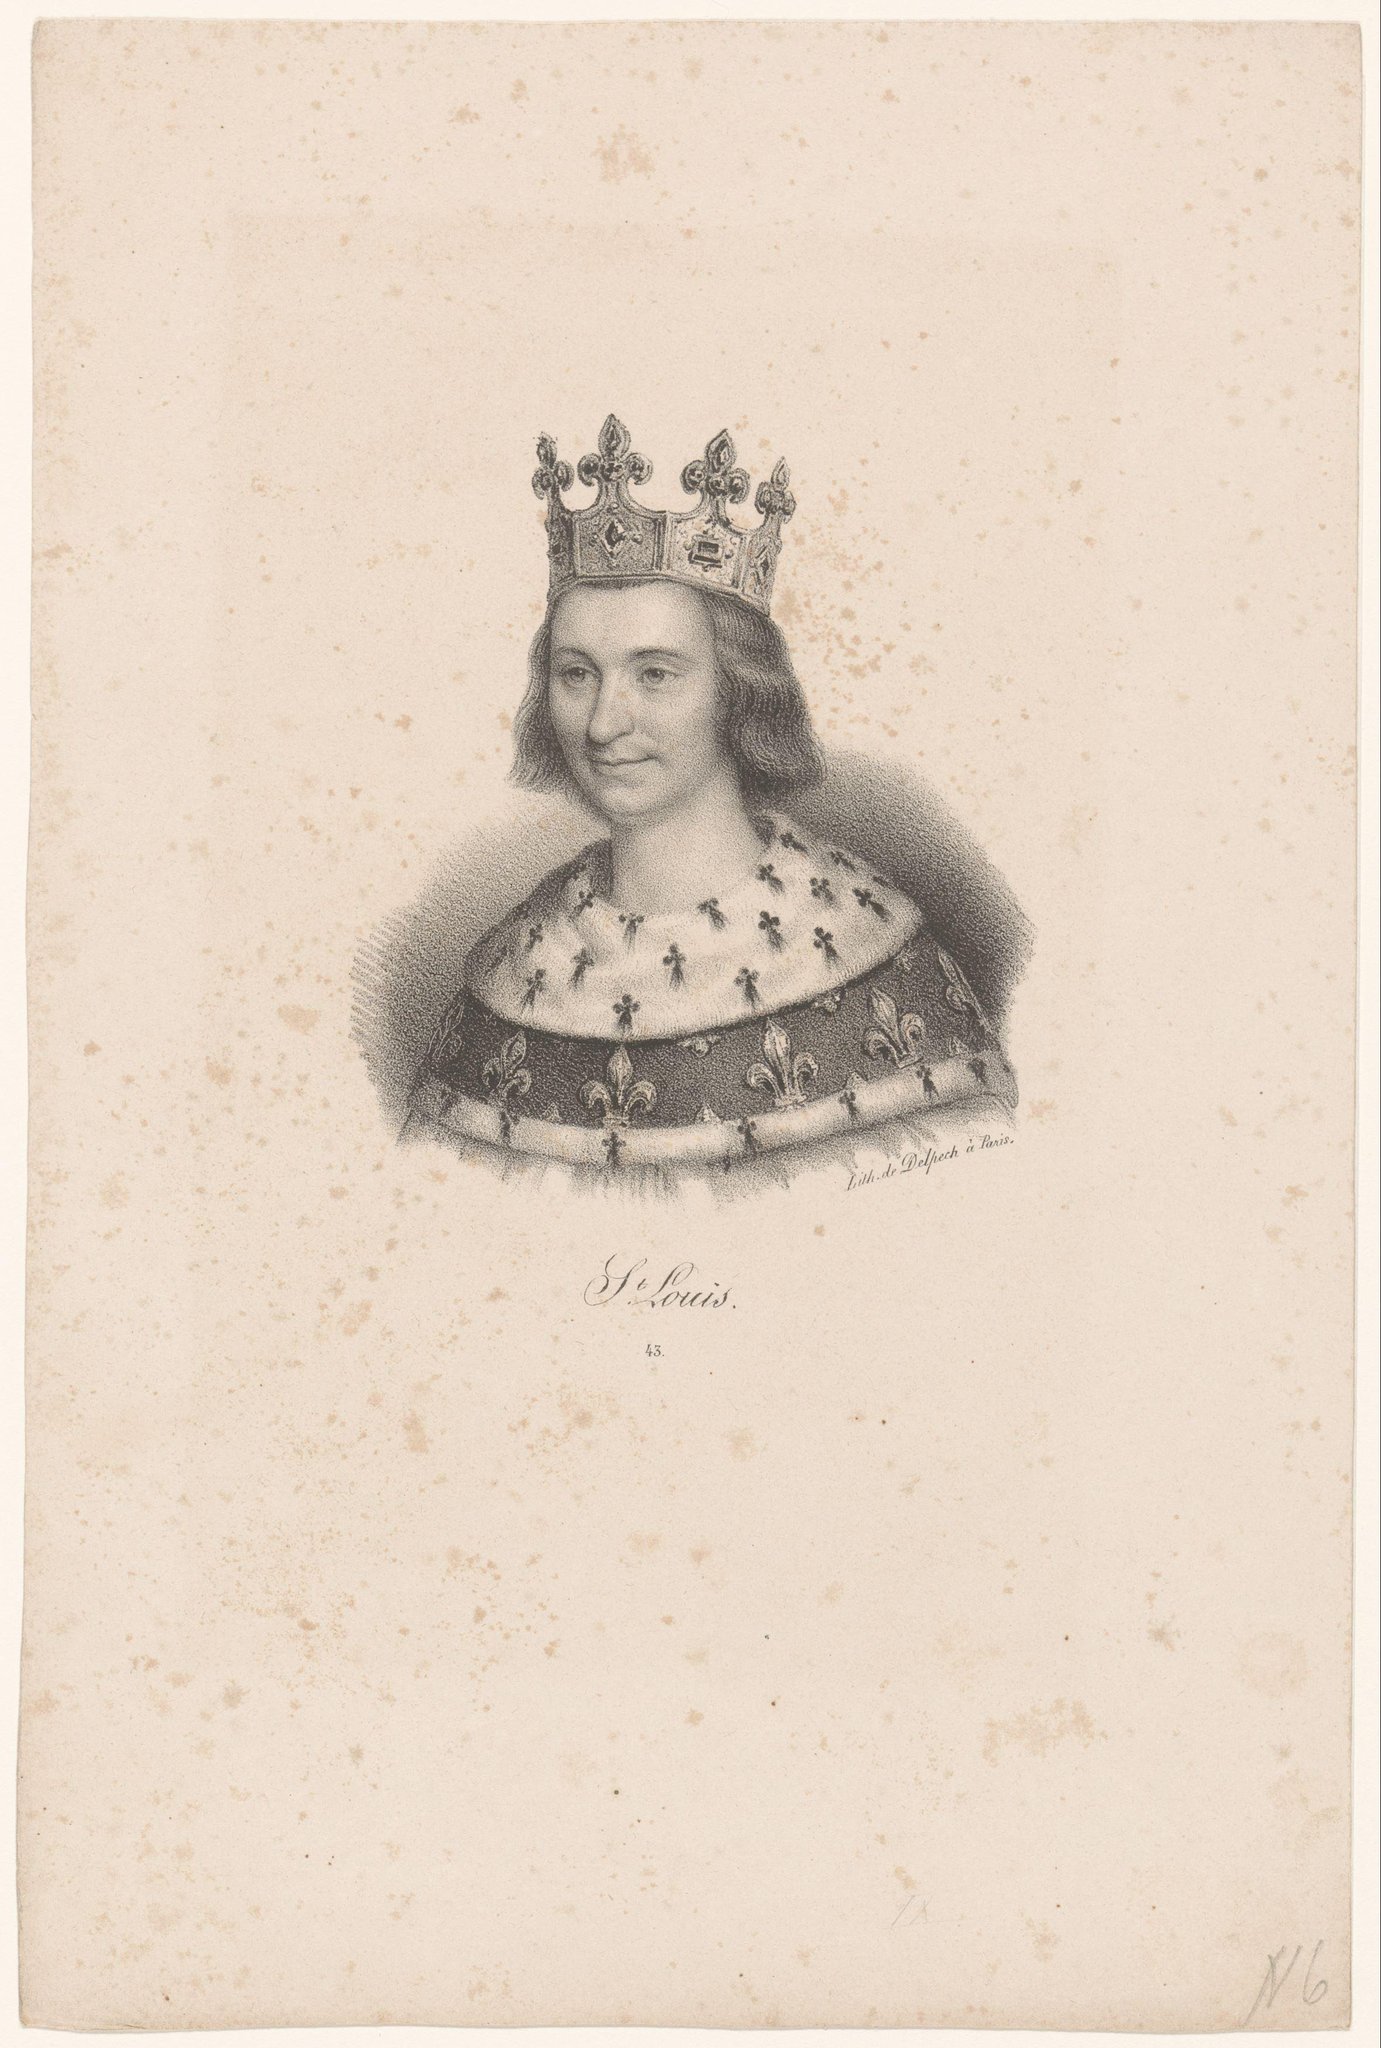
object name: print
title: St. Louis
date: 1818-1842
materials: paper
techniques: lithograph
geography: paris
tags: historical persons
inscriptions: collector's mark: Lugt 2228a